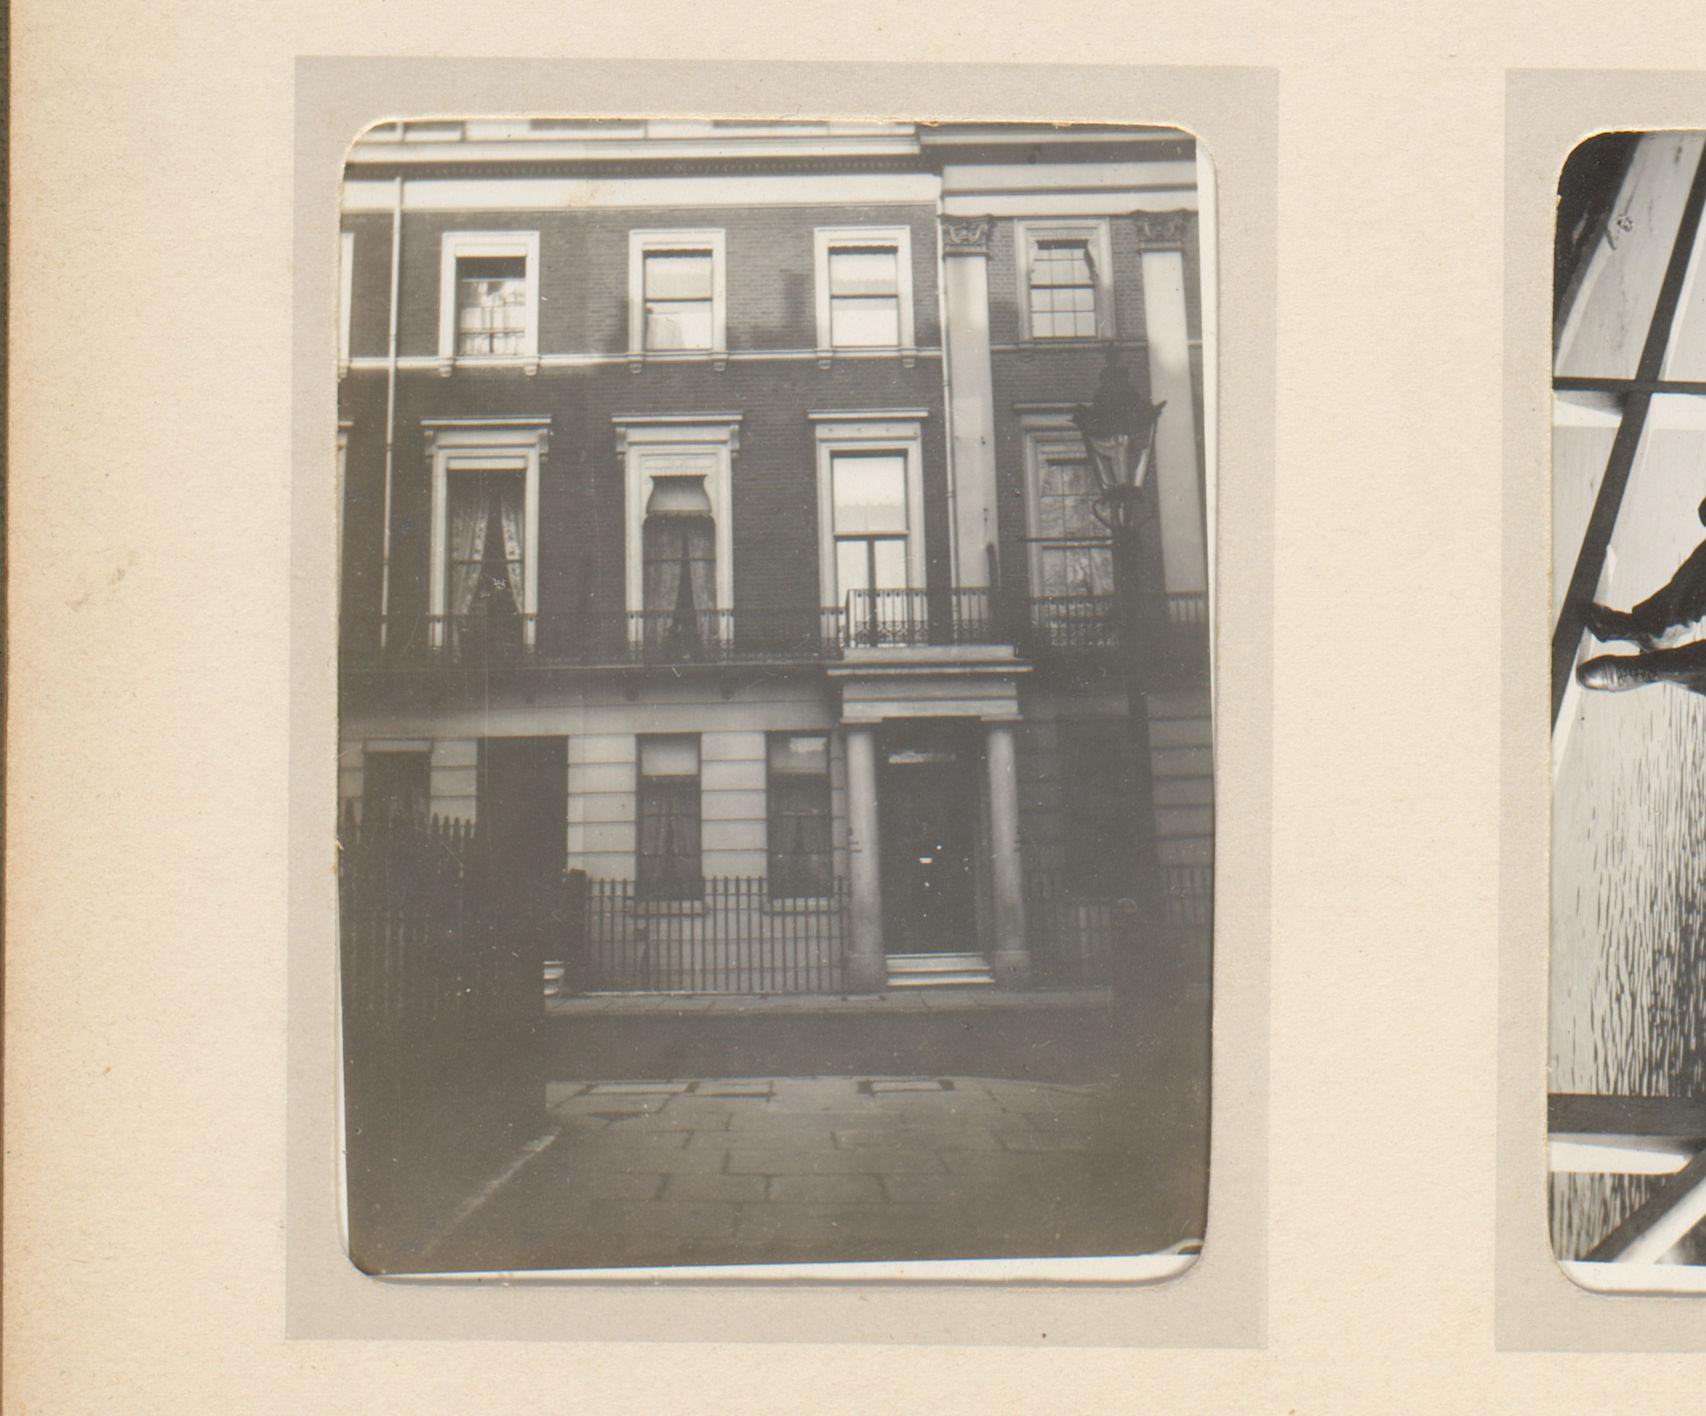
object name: photograph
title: Gevel van Norfolk Crescent 25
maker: liesbeth overhoff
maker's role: fotograaf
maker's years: 1895-1969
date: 1912-1913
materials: paper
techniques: gelatin silver print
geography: london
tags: façade (of house or building)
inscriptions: inscription: ‘Norfolk Crescent 25.’